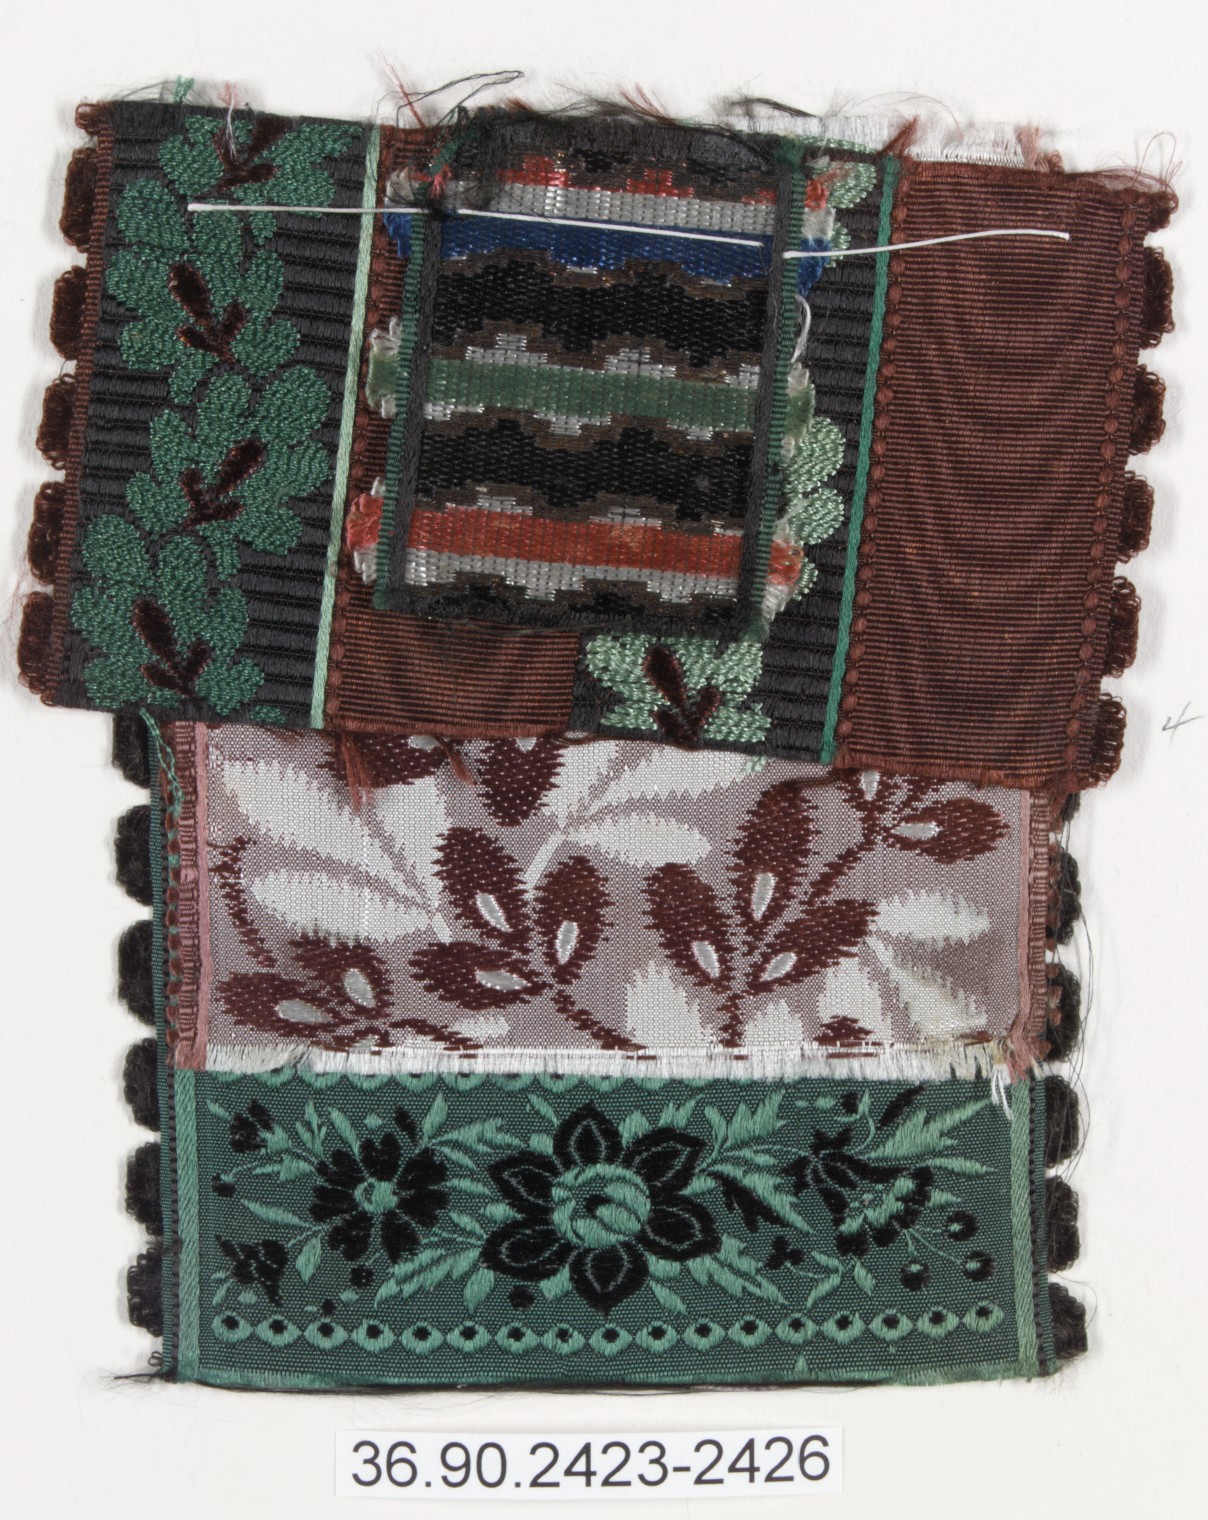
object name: ribbon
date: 1801-1900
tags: flowers